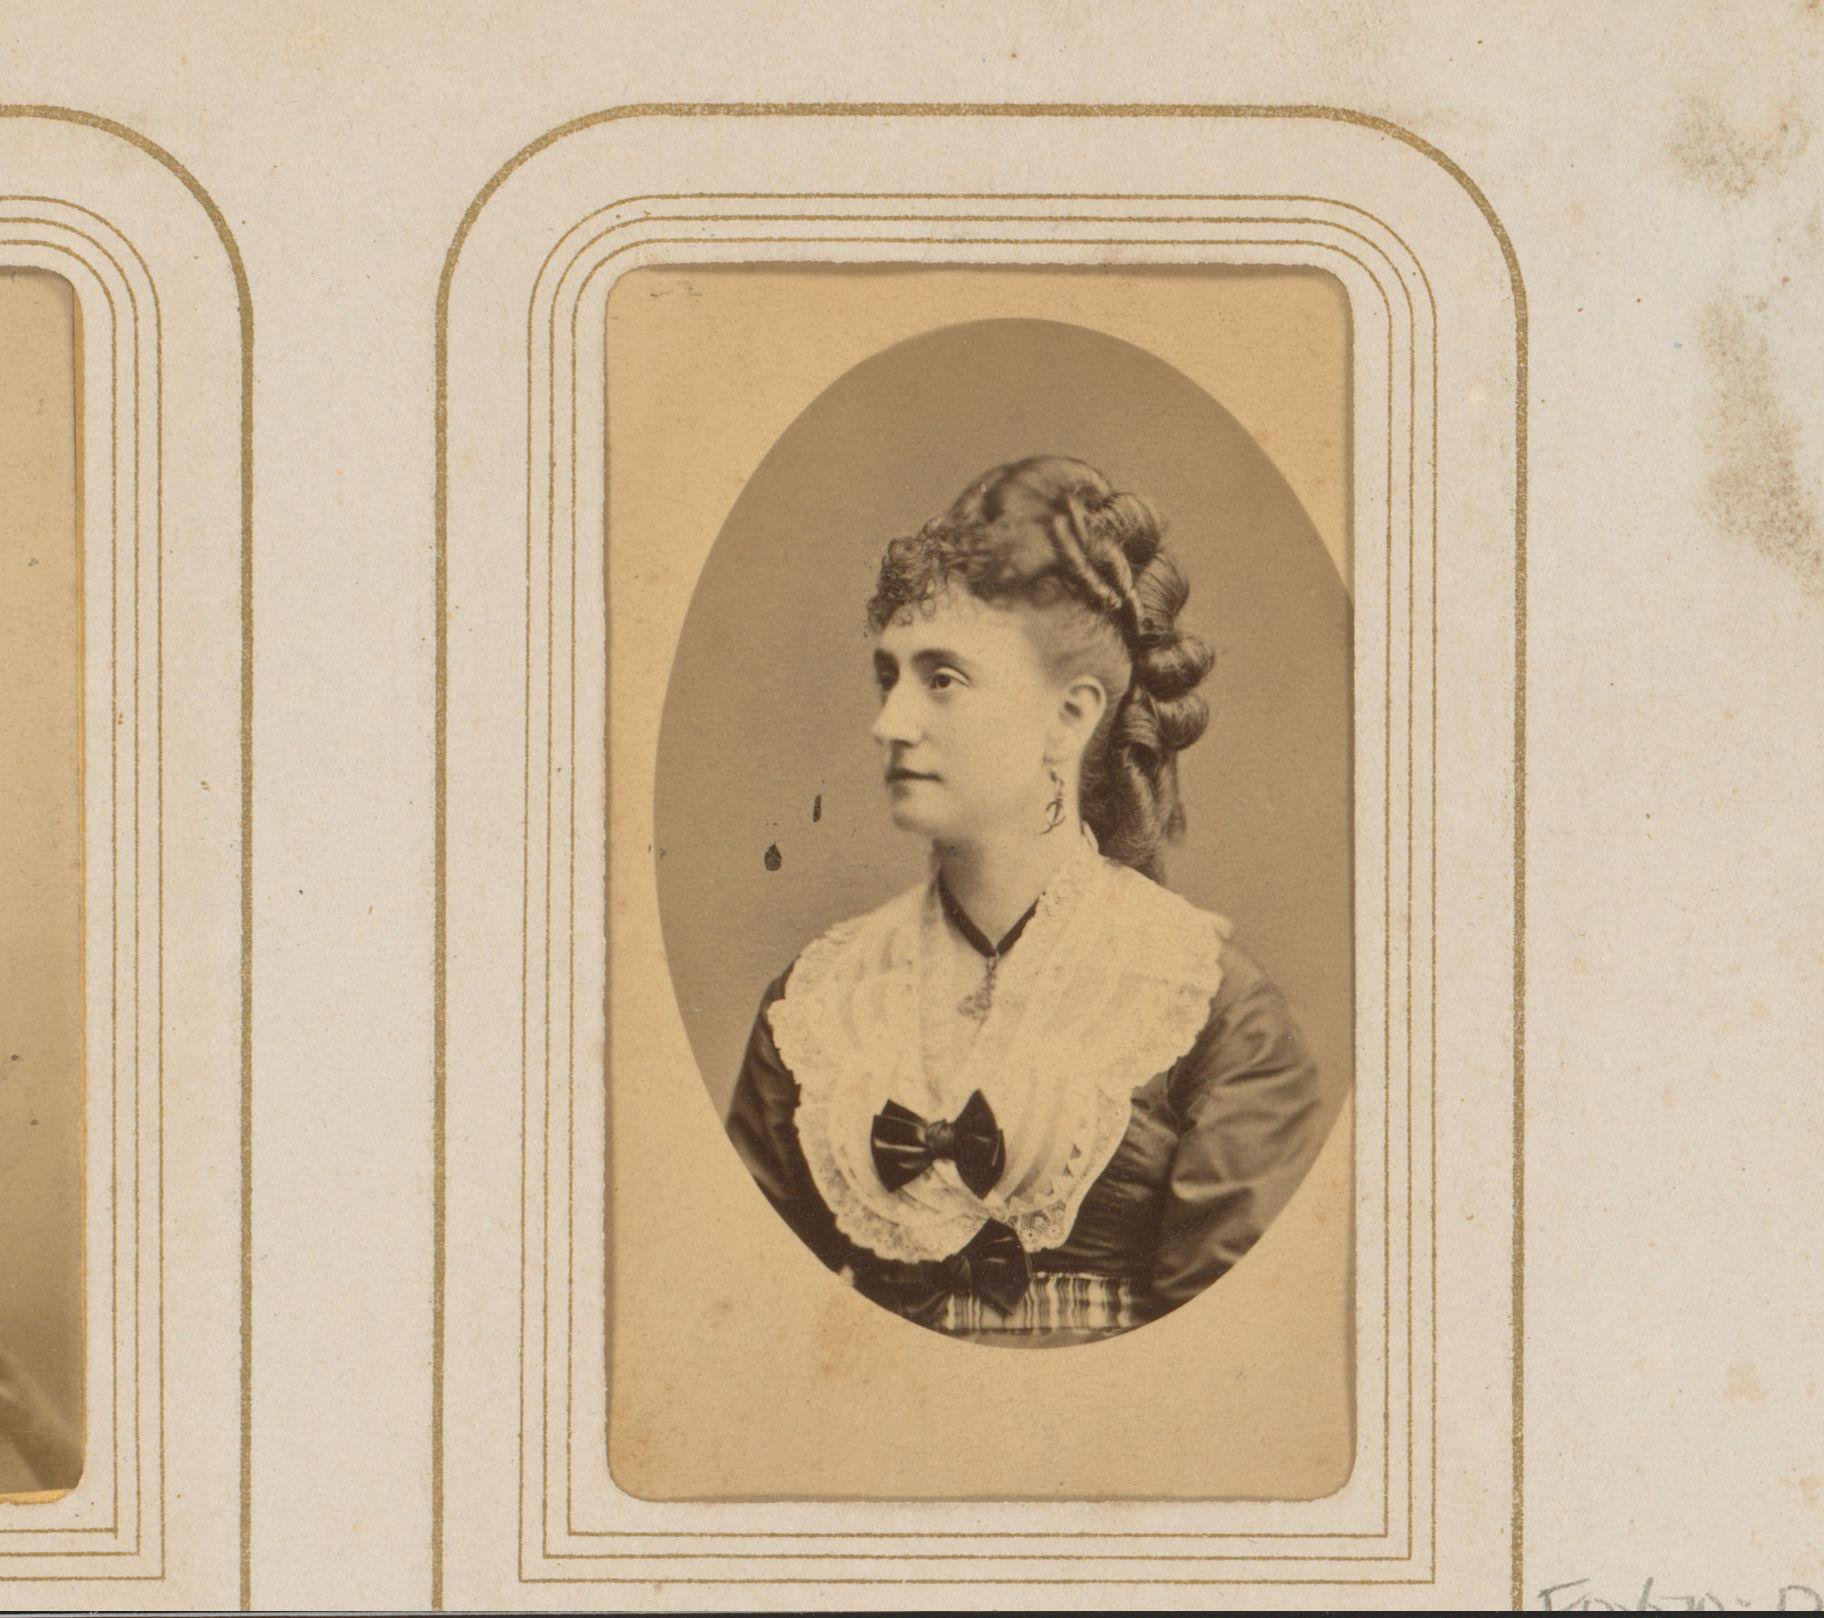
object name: album leaf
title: Portret van een vrouw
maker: anatole pougnet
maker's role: publisher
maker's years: 1840-1900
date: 1860-1880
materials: cardboard, photographic support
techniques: albumen print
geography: paris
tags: historical persons - bb - woman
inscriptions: annotation: ‘Malvina (Pougnet)’, inscription: ‘Anatole Pougnet/ Éditeur/ 61, Boulevard Sébastopol/ Paris’, name: ‘Malvina’